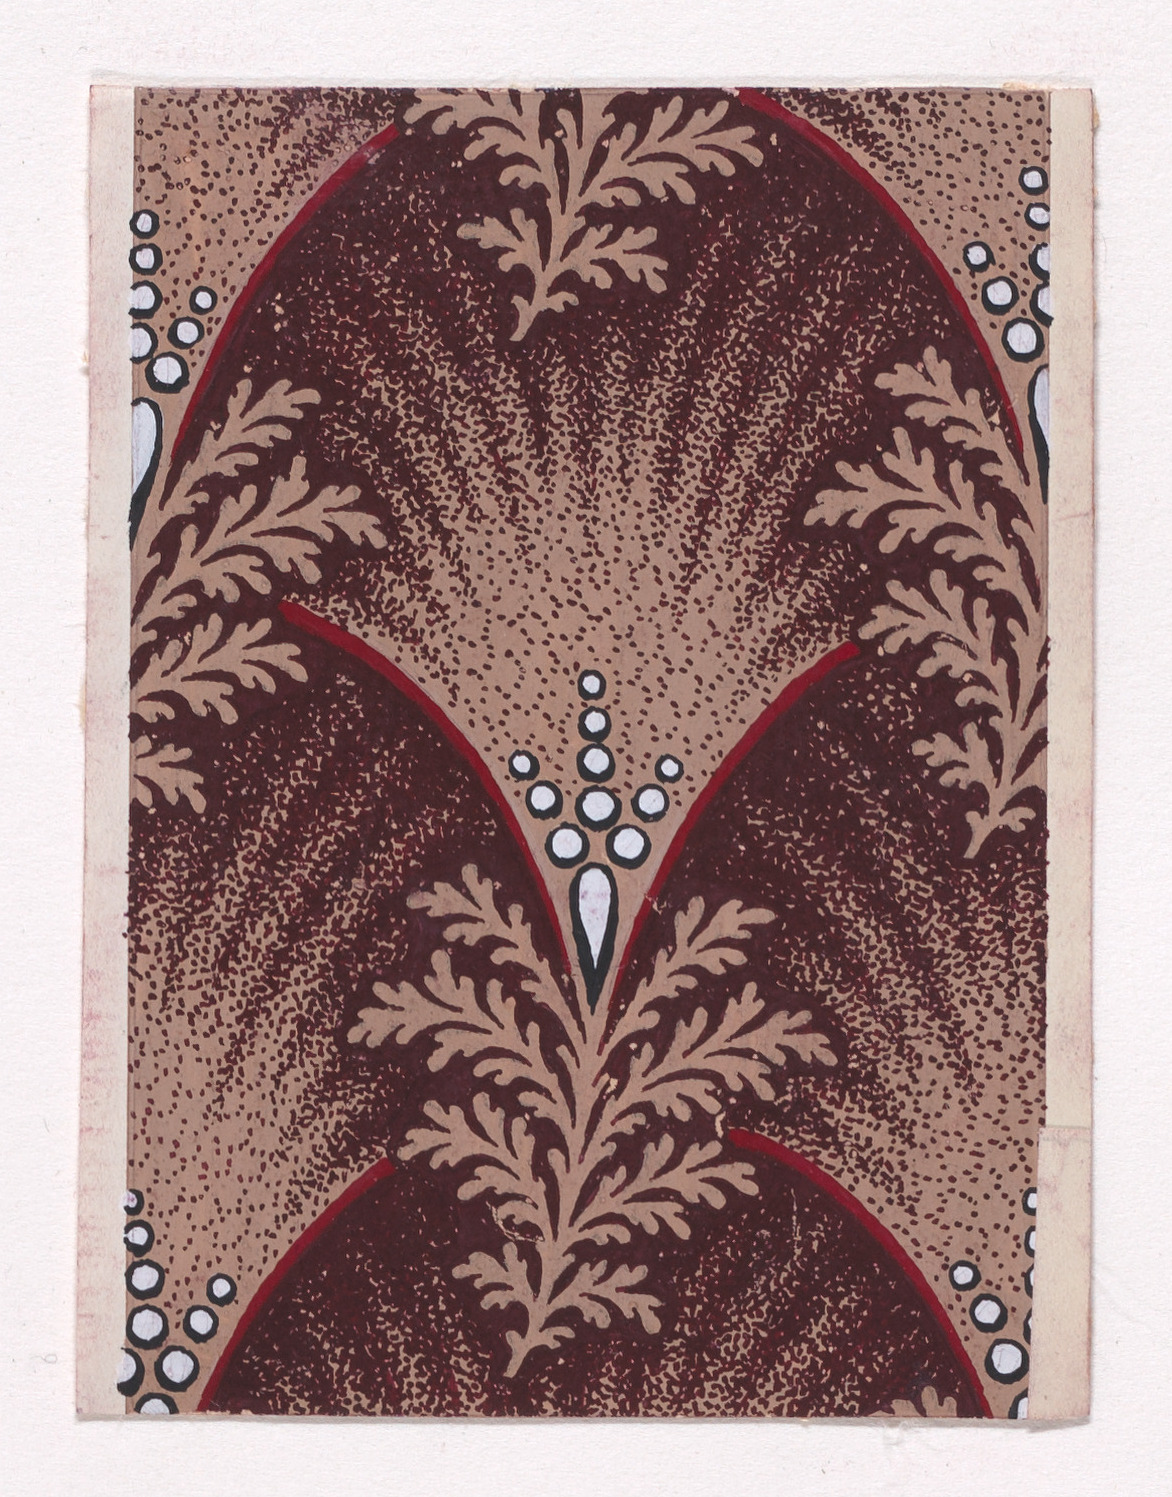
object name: drawing ornament architecture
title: Textile Design with Alternating Palmettes Decorated with Pearls Flanked by Bundles of Leaves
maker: anonymous, alsatian, 19th century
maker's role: artist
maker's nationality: alsatian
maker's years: 1800-1900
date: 1840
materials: gouache